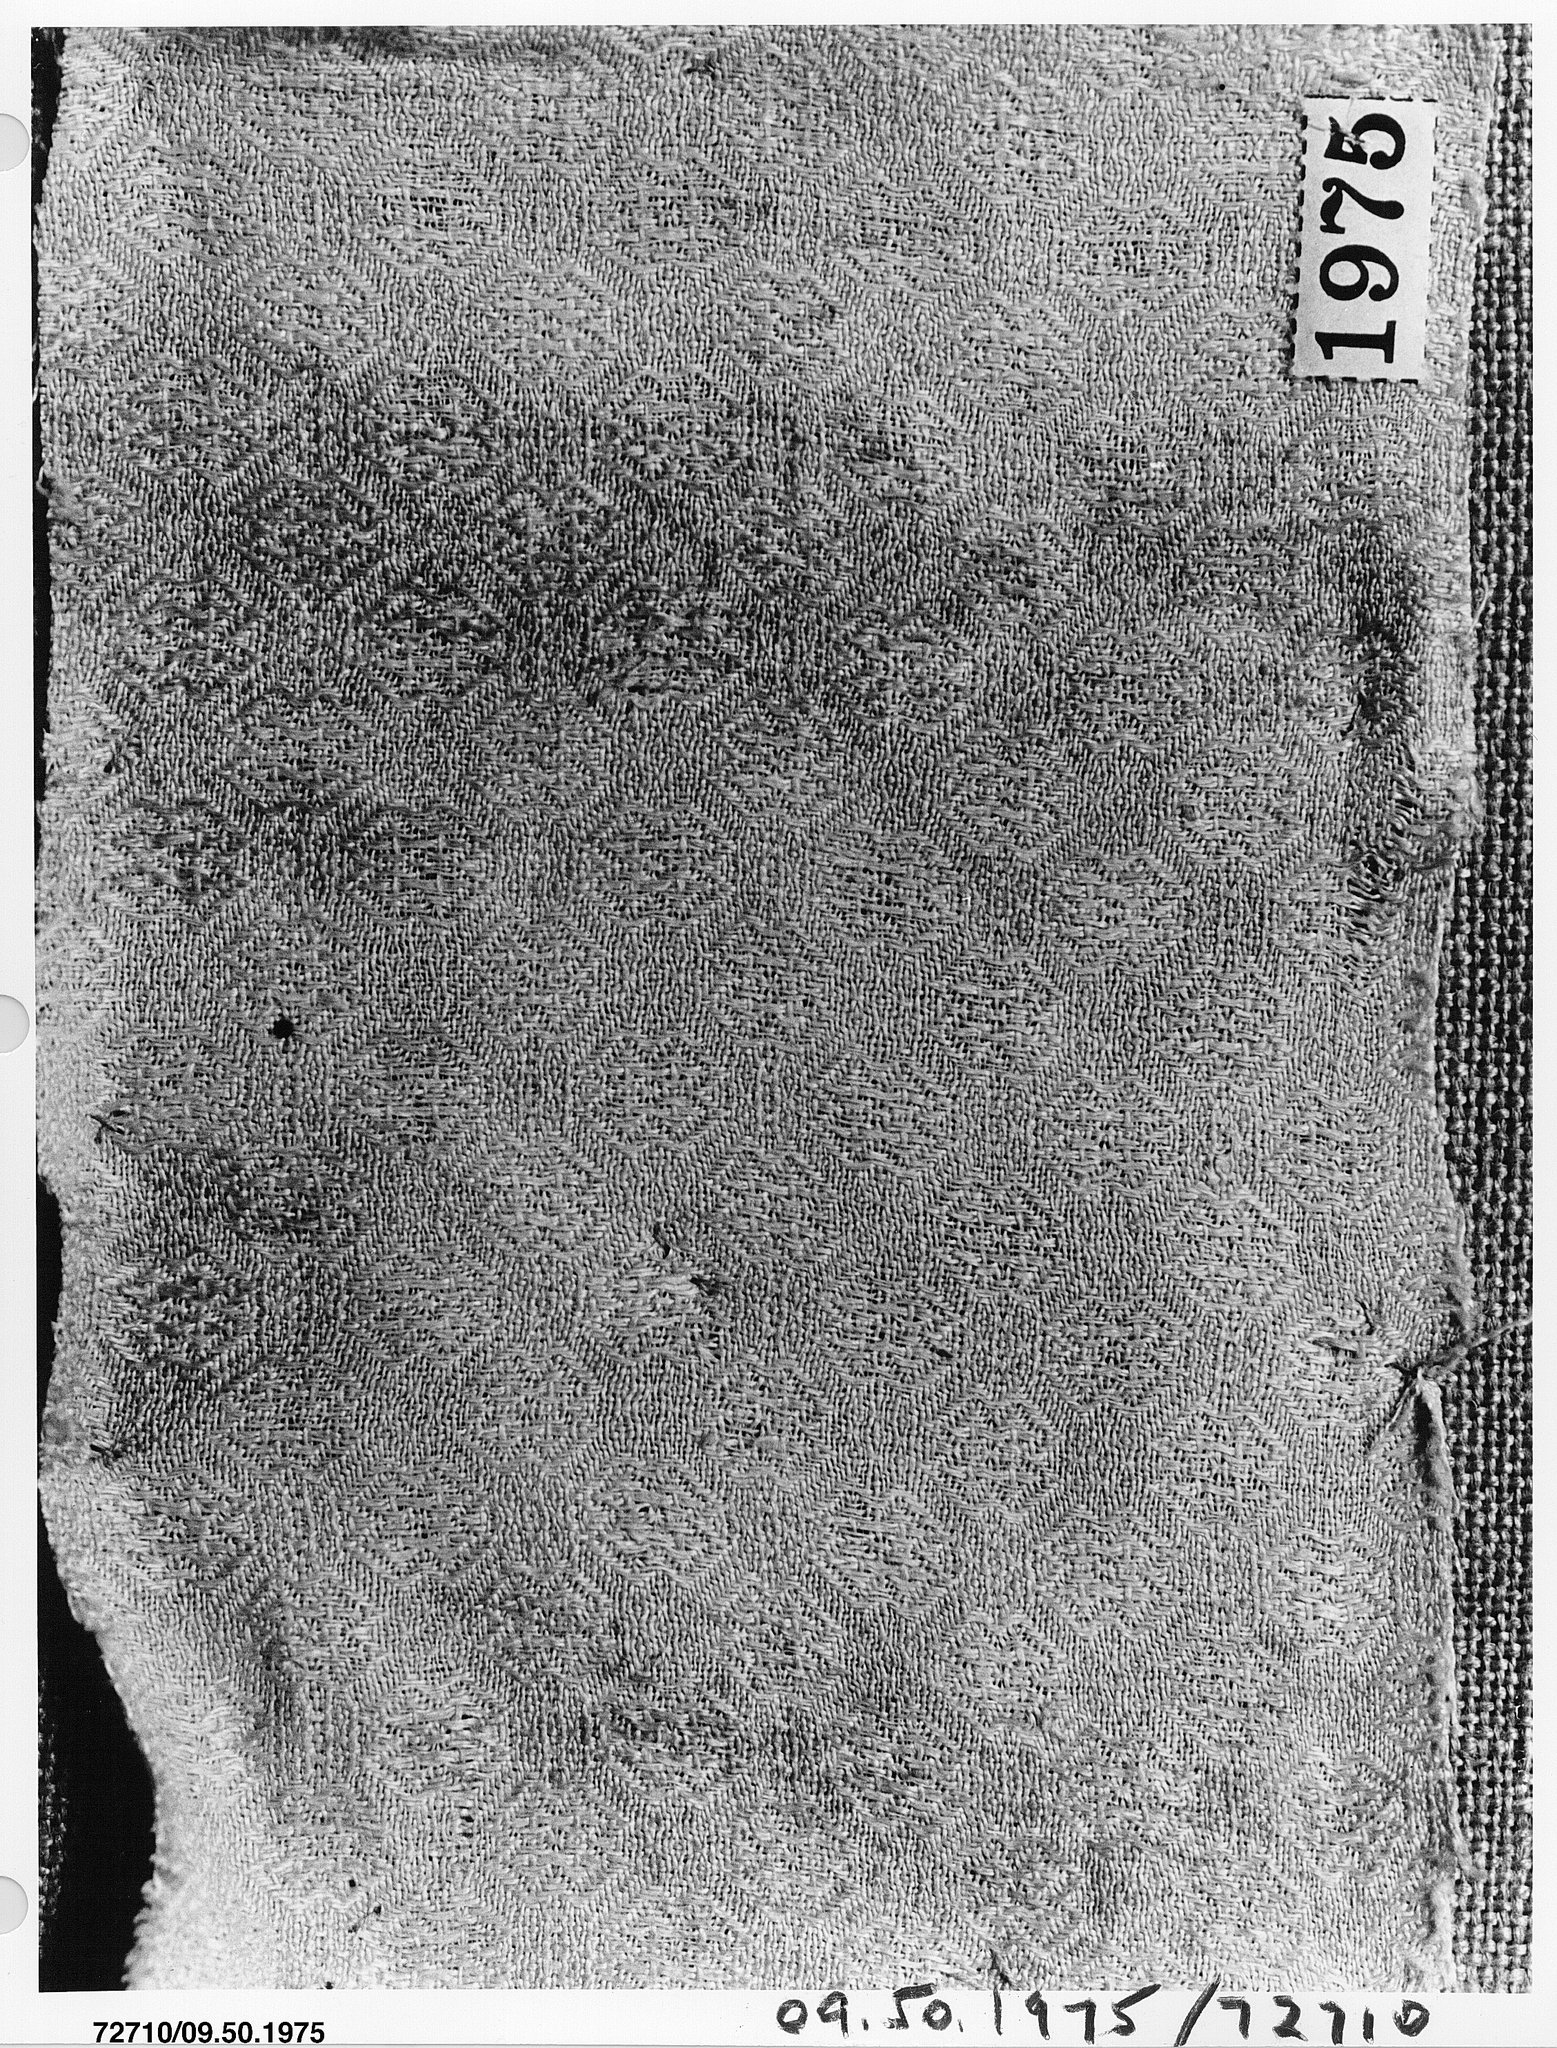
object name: piece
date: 1701-1900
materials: linen